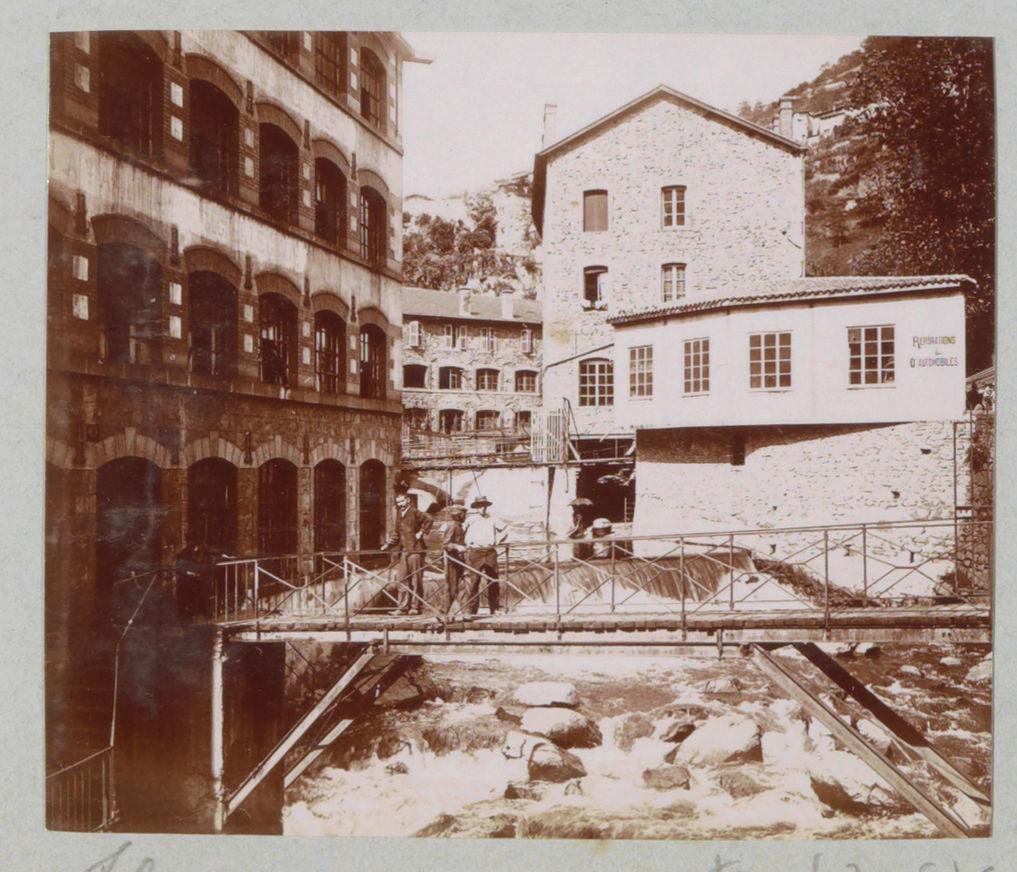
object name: photograph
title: Huizen, brug en waterval in Thiers met rechts een bedrijf voor autoreparatie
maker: delizy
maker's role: manufacturer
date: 1903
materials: paper, photographic support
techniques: gelatin silver print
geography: thiers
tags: repair shop, garage for repairs, supplies etc., waterfall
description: Onderdeel van Fotoalbum van een Franse amateurfotograaf met opnames van uitstapjes in Frankrijk, Spanje, België, Luxemburg en Nederland, de eerste automobielen en autoraces.